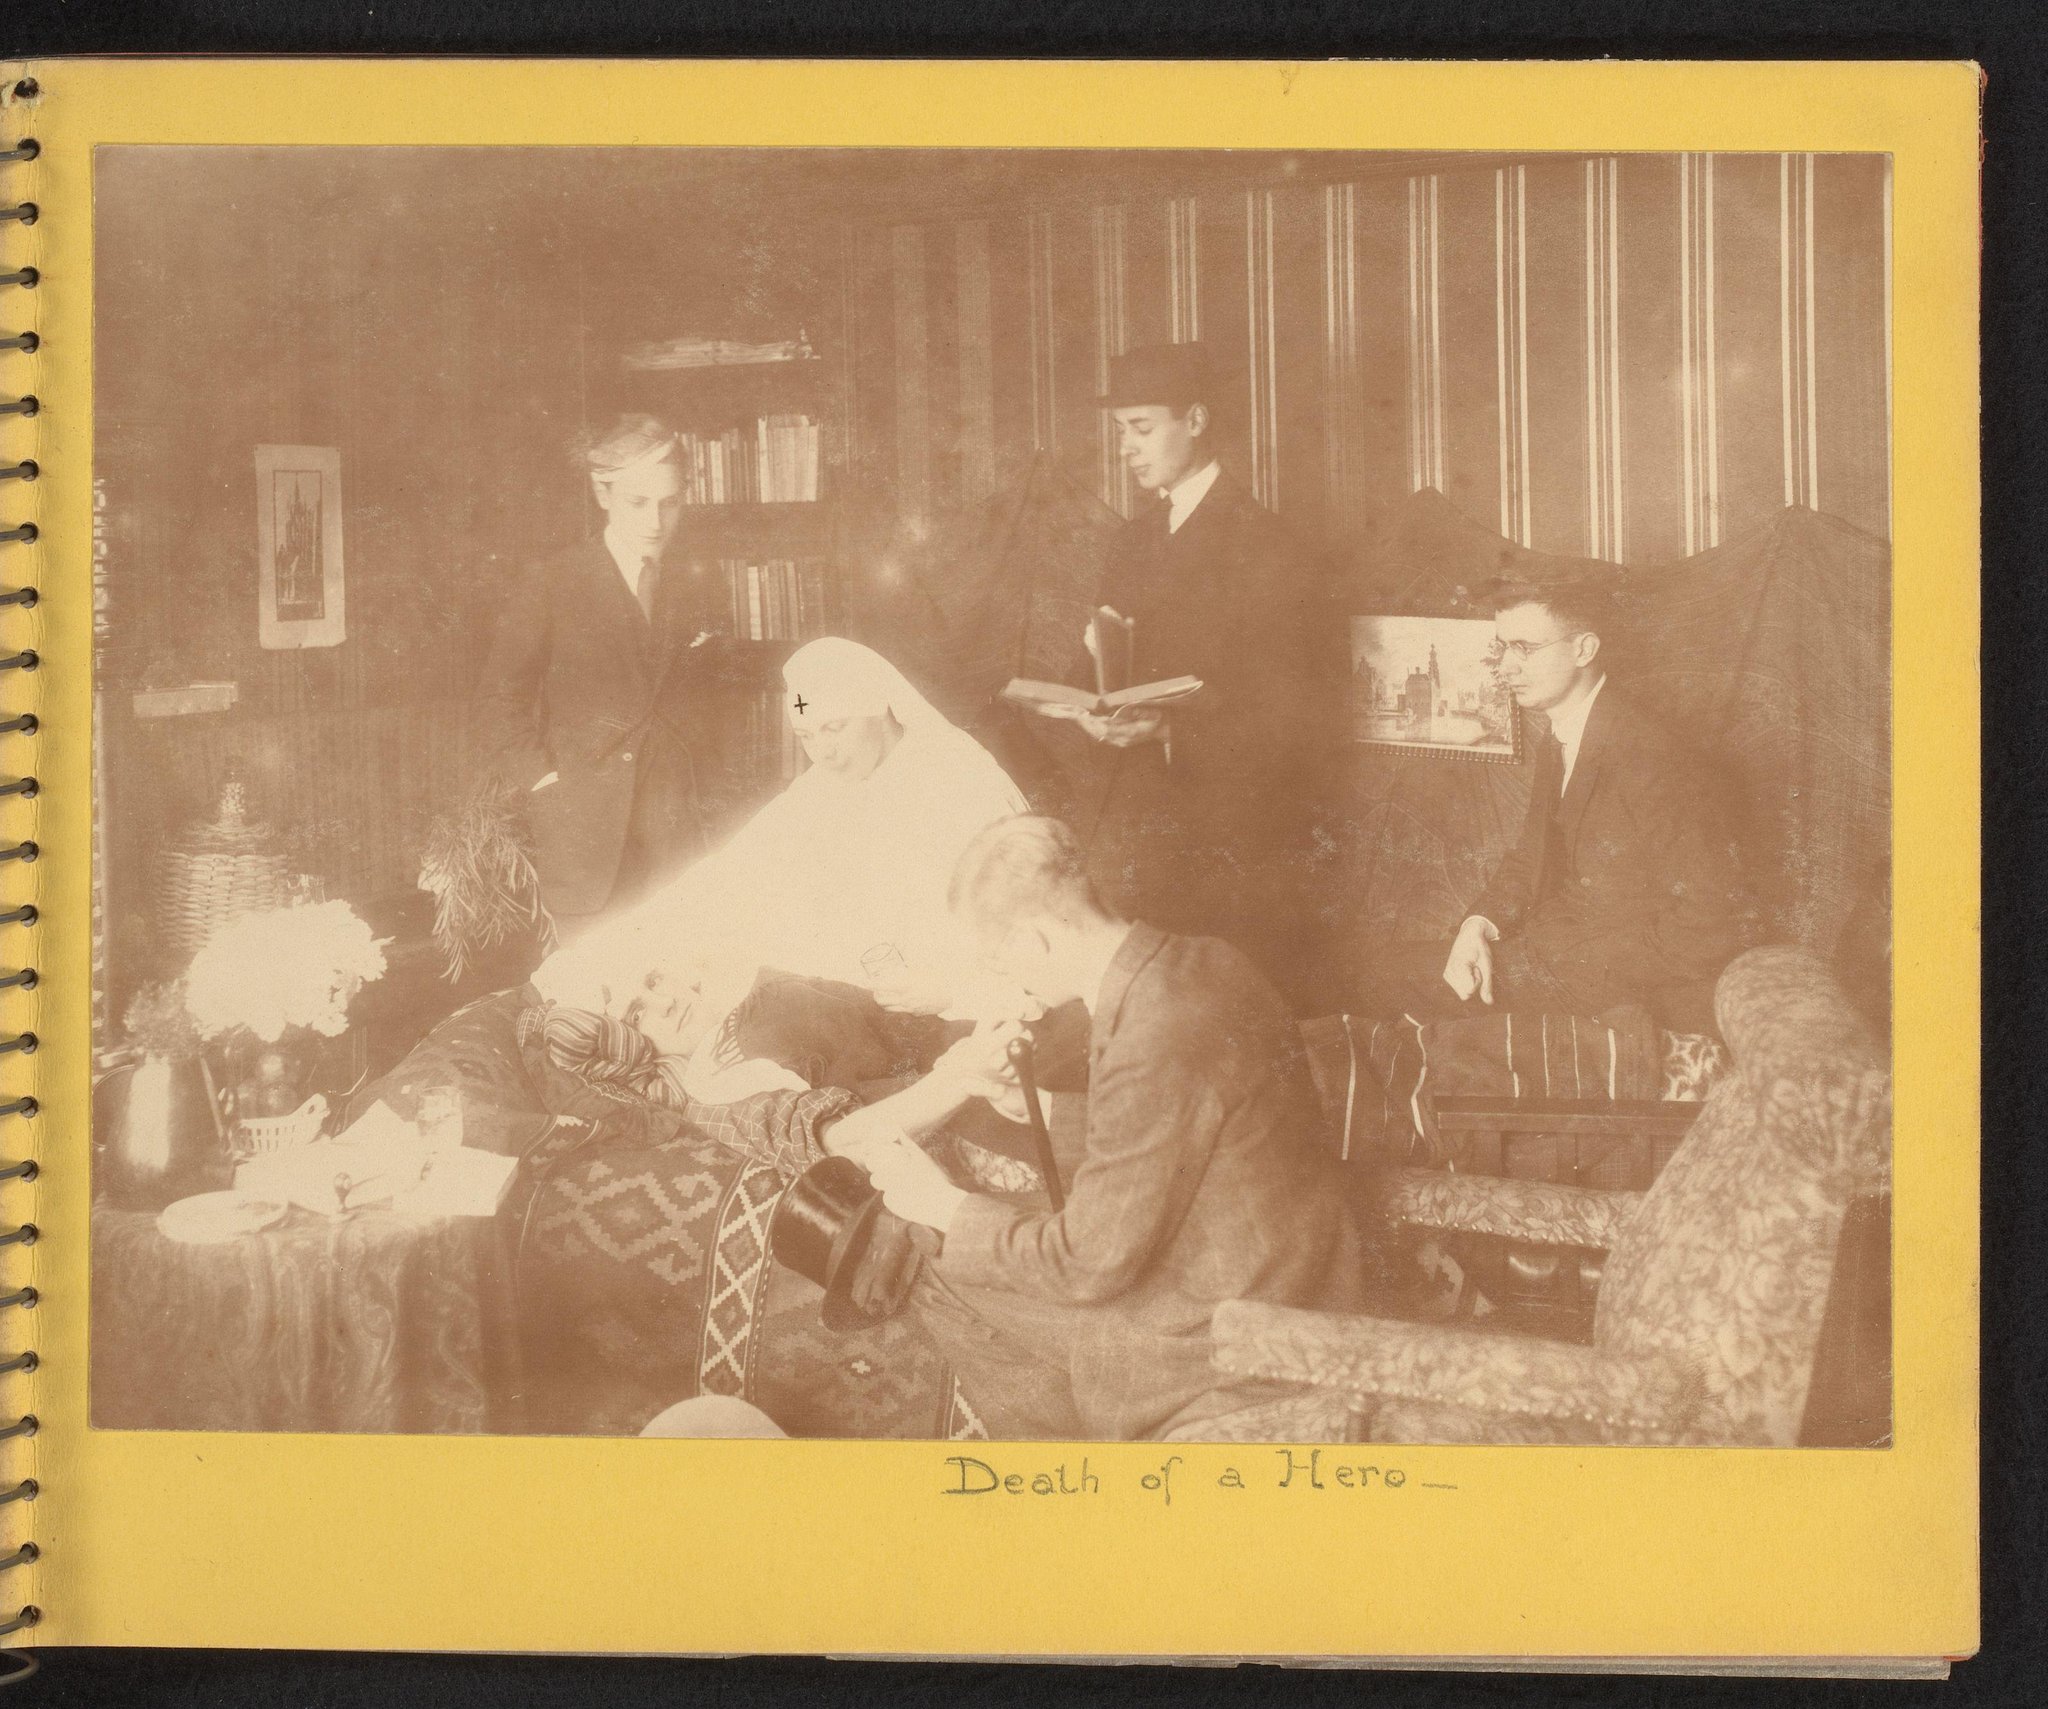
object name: photograph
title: Geënsceneerd ziekbed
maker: Anonymous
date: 1924-1932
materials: photographic support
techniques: gelatin silver print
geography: netherlands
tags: nursing, tending the sick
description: Geënsceneerde scène (toneelstuk?) met een verpleegster en vier mannen rond een patient. Onderdeel van een fotoalbum over de bewoners van het huis aan de Reguliersgracht te Amsterdam in de periode 1924-1932.